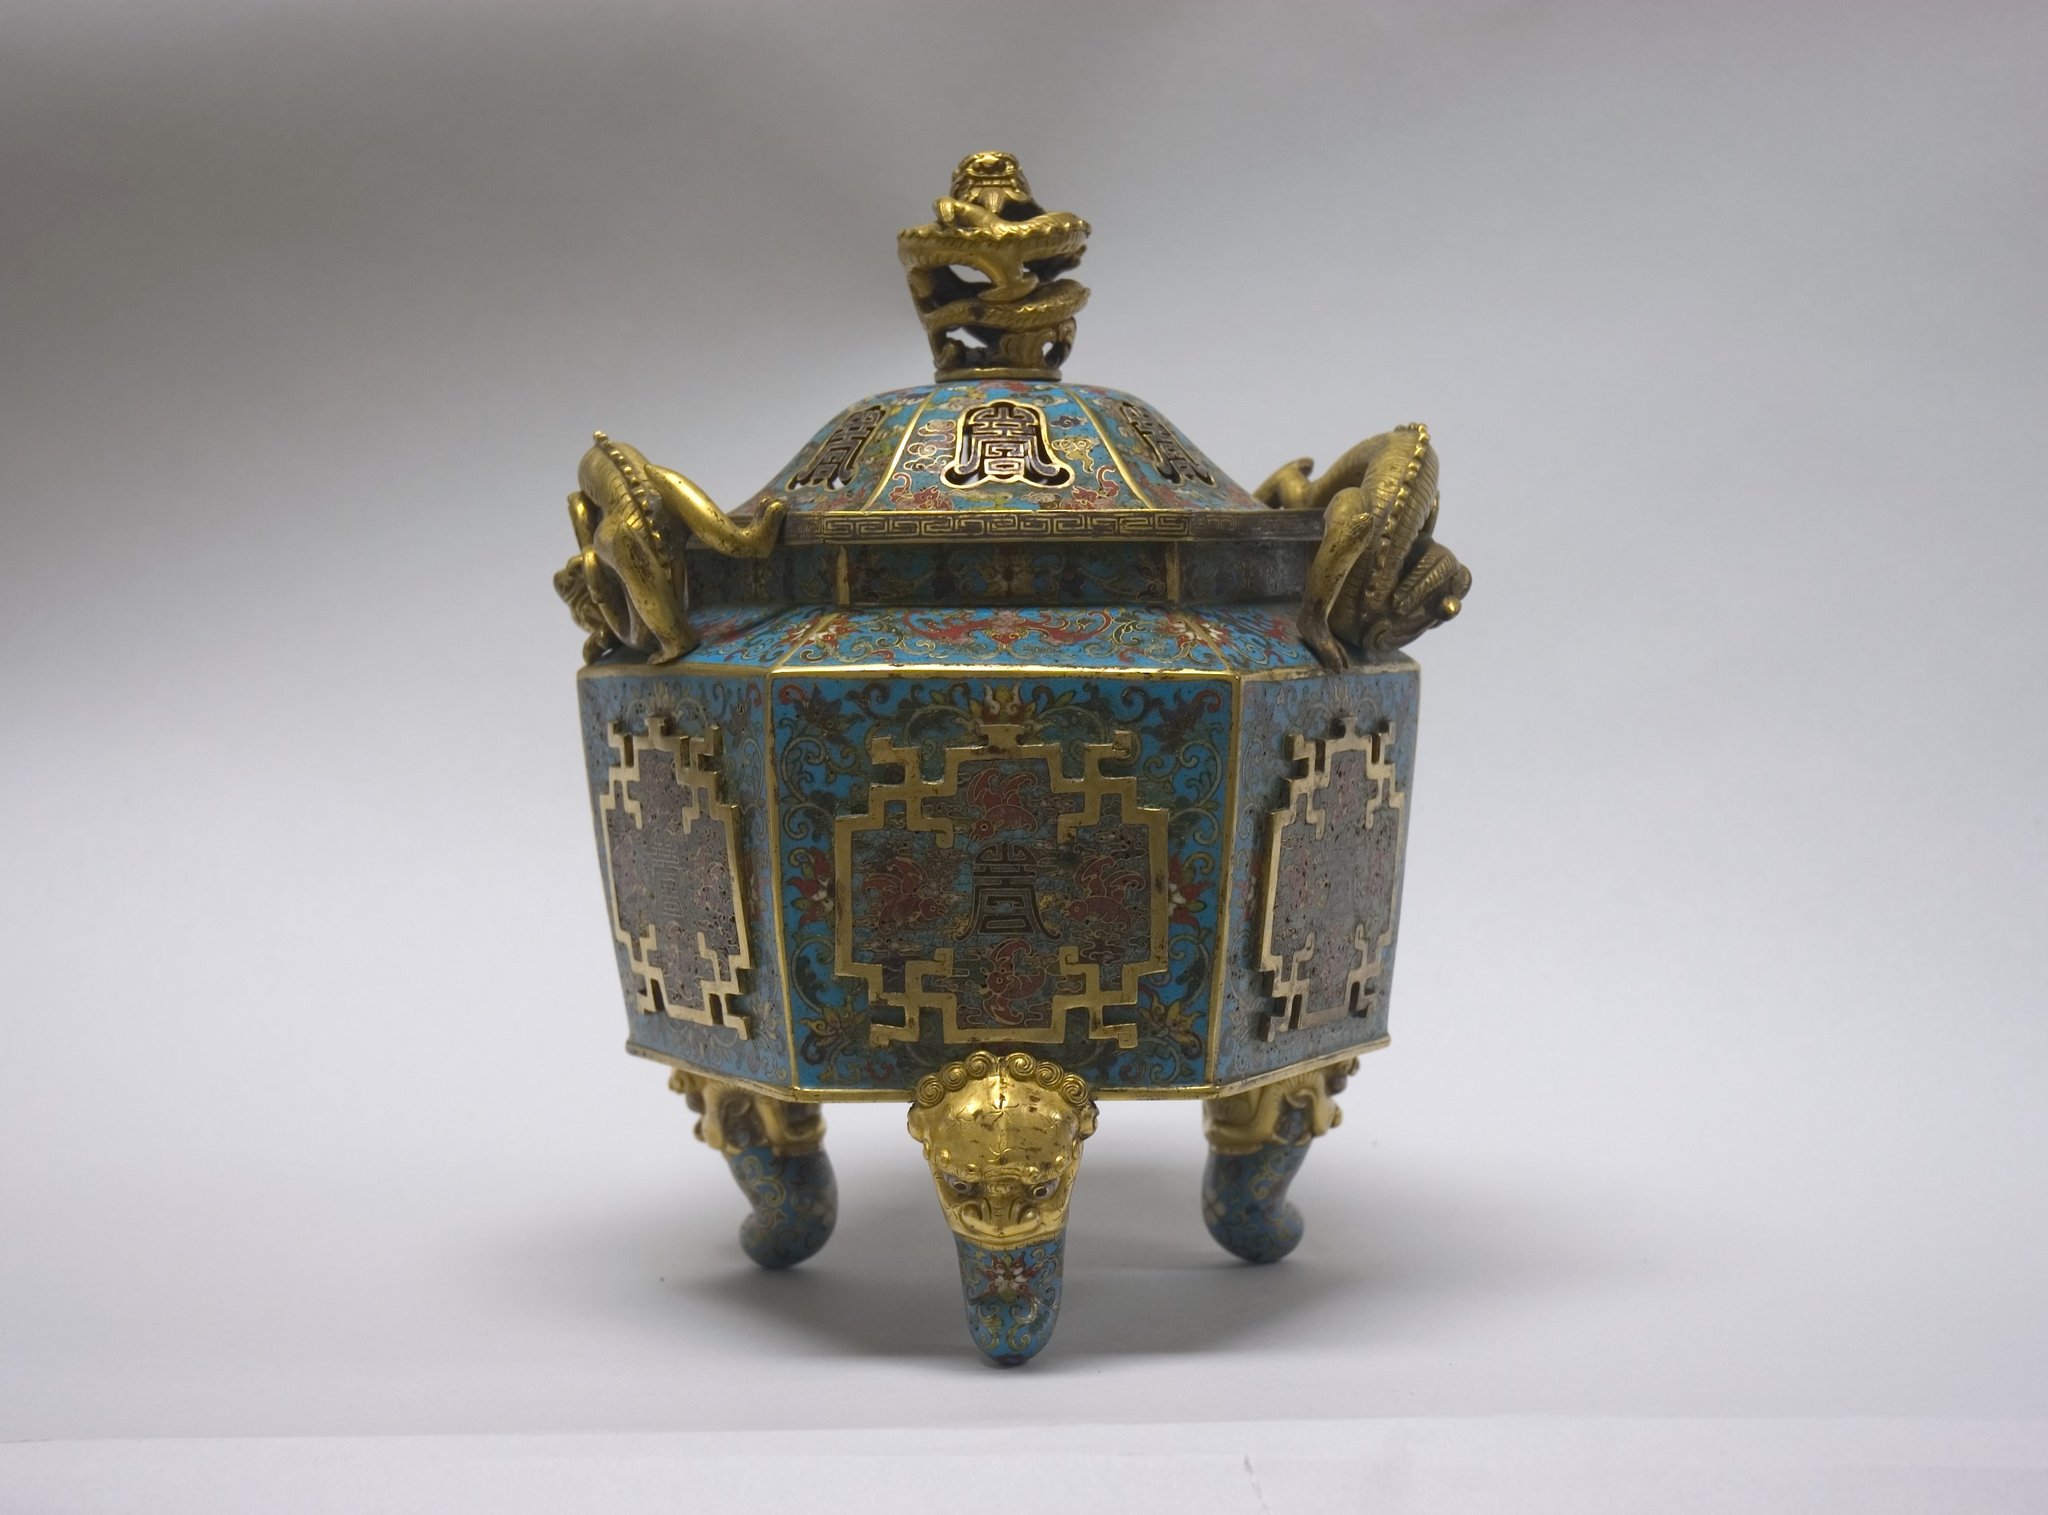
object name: covered incense burner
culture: chinese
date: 1662-1722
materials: copper, enamel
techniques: enamel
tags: dragons